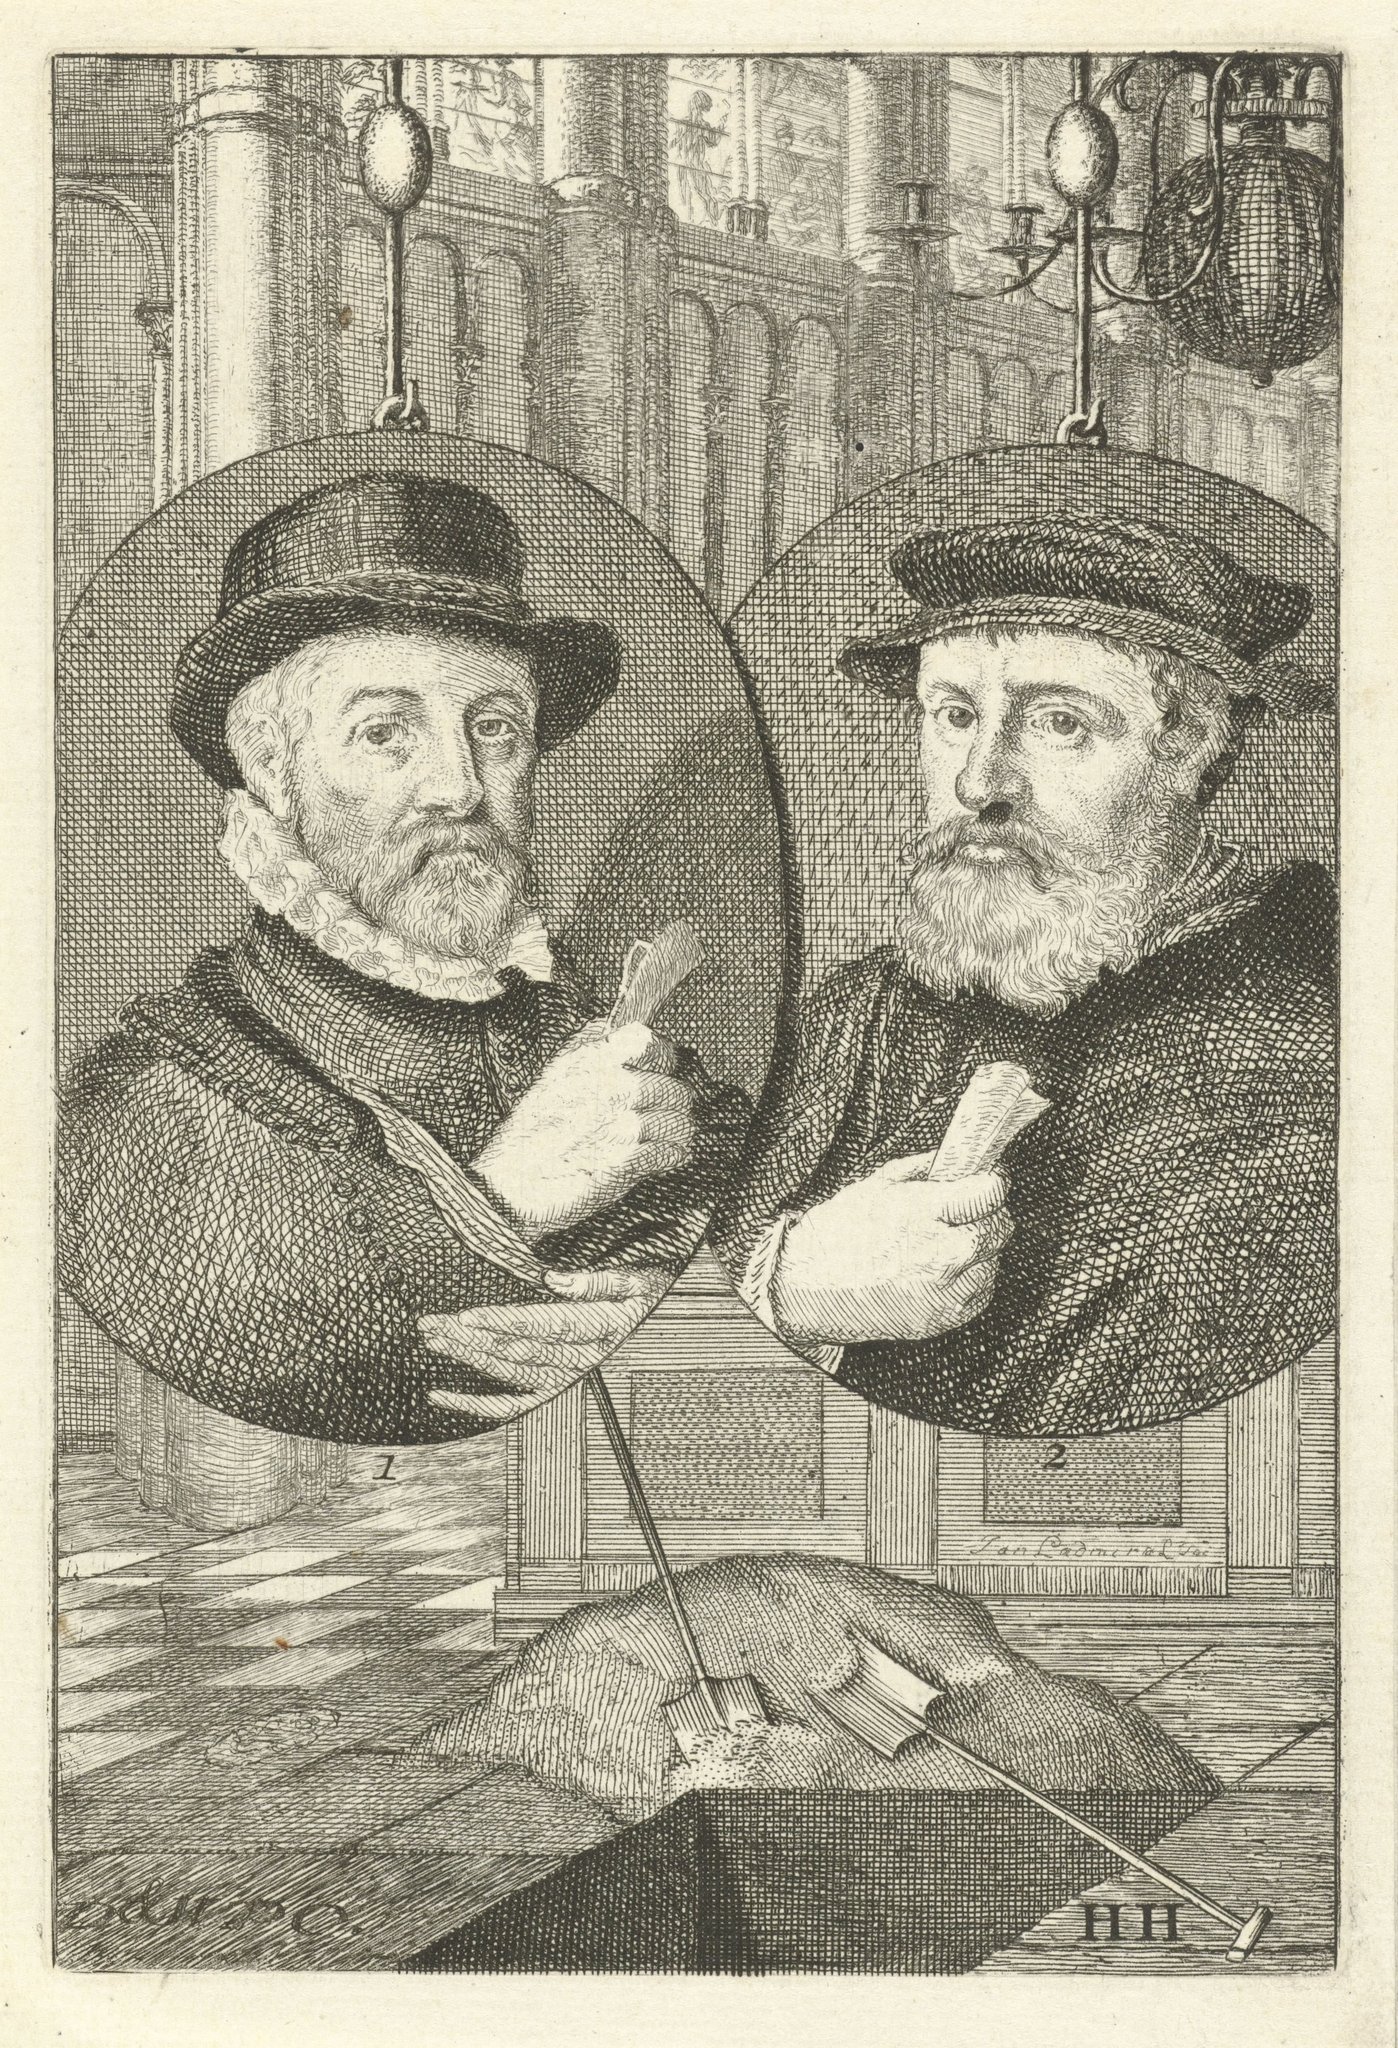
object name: print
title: Dubbelportret van Dirck en Wouter Pietersz. Crabeth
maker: jan l admiral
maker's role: draughtsman, print maker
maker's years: 1699-1773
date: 1764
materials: paper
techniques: etching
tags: dirck pietersz. crabeth, gouda, draughtsman, designer, wouter pietersz i crabeth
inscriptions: collector's mark: Lugt 2228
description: Prent opgenomen in: Mander, Karel van; Jongh, Jacobus de (vert.). Het leven der doorluchtige Nederlandsche en eenige Hoogduitsche schilders. Amsterdam: Steven van Esveldt, 1764.